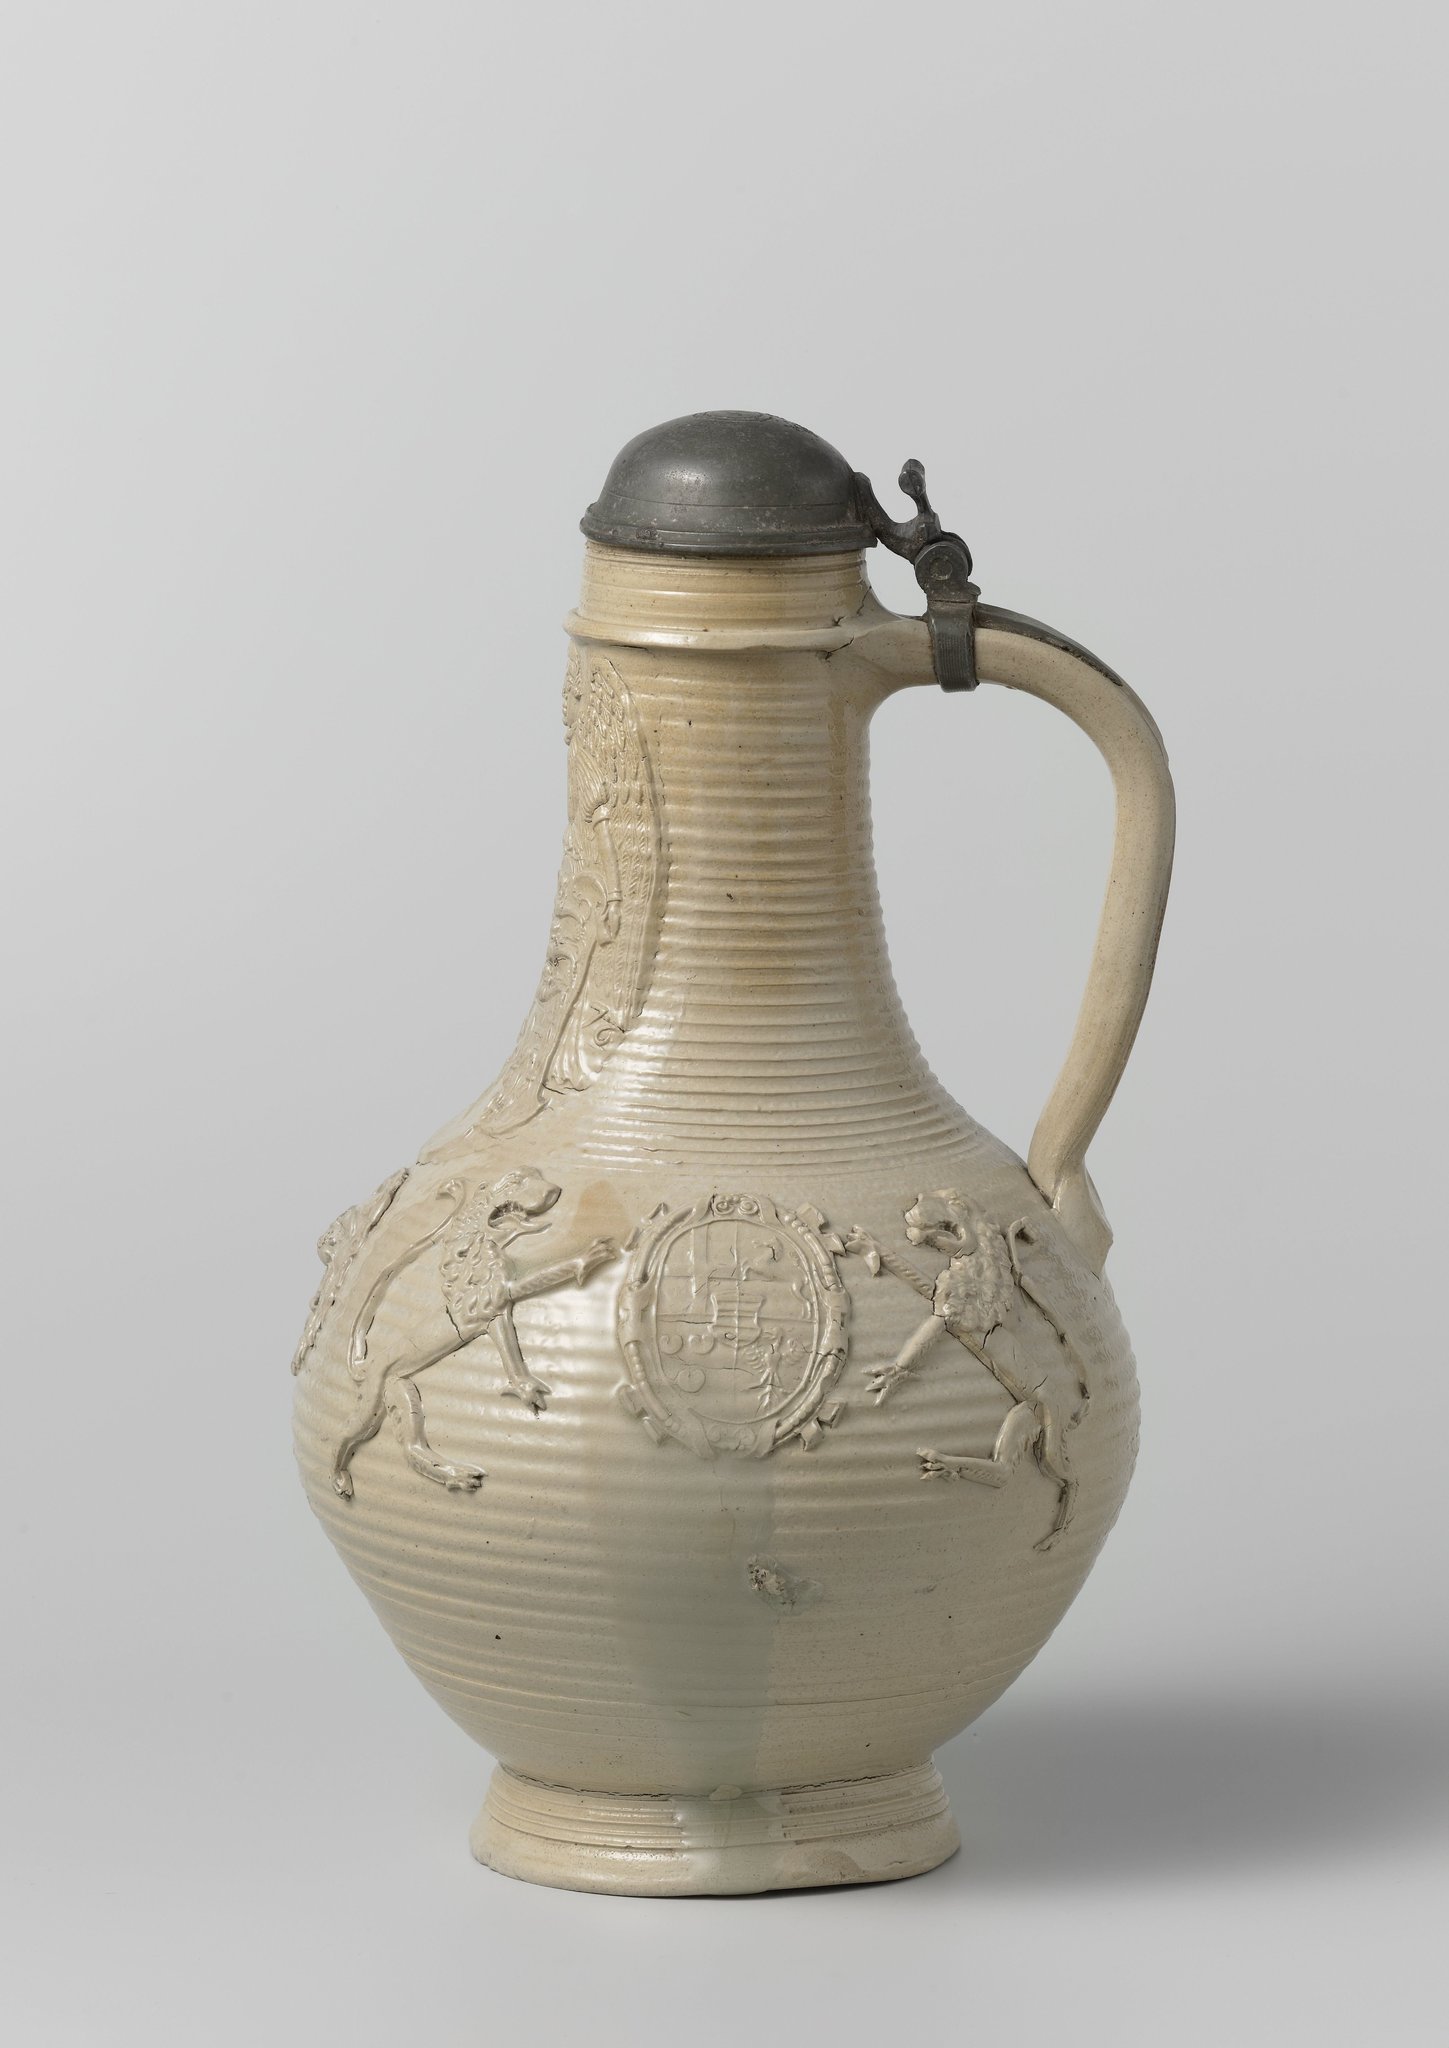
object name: jug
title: Jug with the coat of arms of England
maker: anno knütgen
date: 1576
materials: glaze, stoneware, tin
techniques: firing, forming, relief, turning, vitrification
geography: siegburg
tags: armorial bearing, heraldry, england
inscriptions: date: ‘15 76’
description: The neck of the jug is embellished with an angel bearing the arms of England. The body is decorated twice with the arms of Salentin von Isenburg-Grenzau (Archbishop of Cologne) between two rampant lions. There does not seem to be any connection between the English and the Cologne coats of arms; the potter simply used the templates available to him in the workshop.